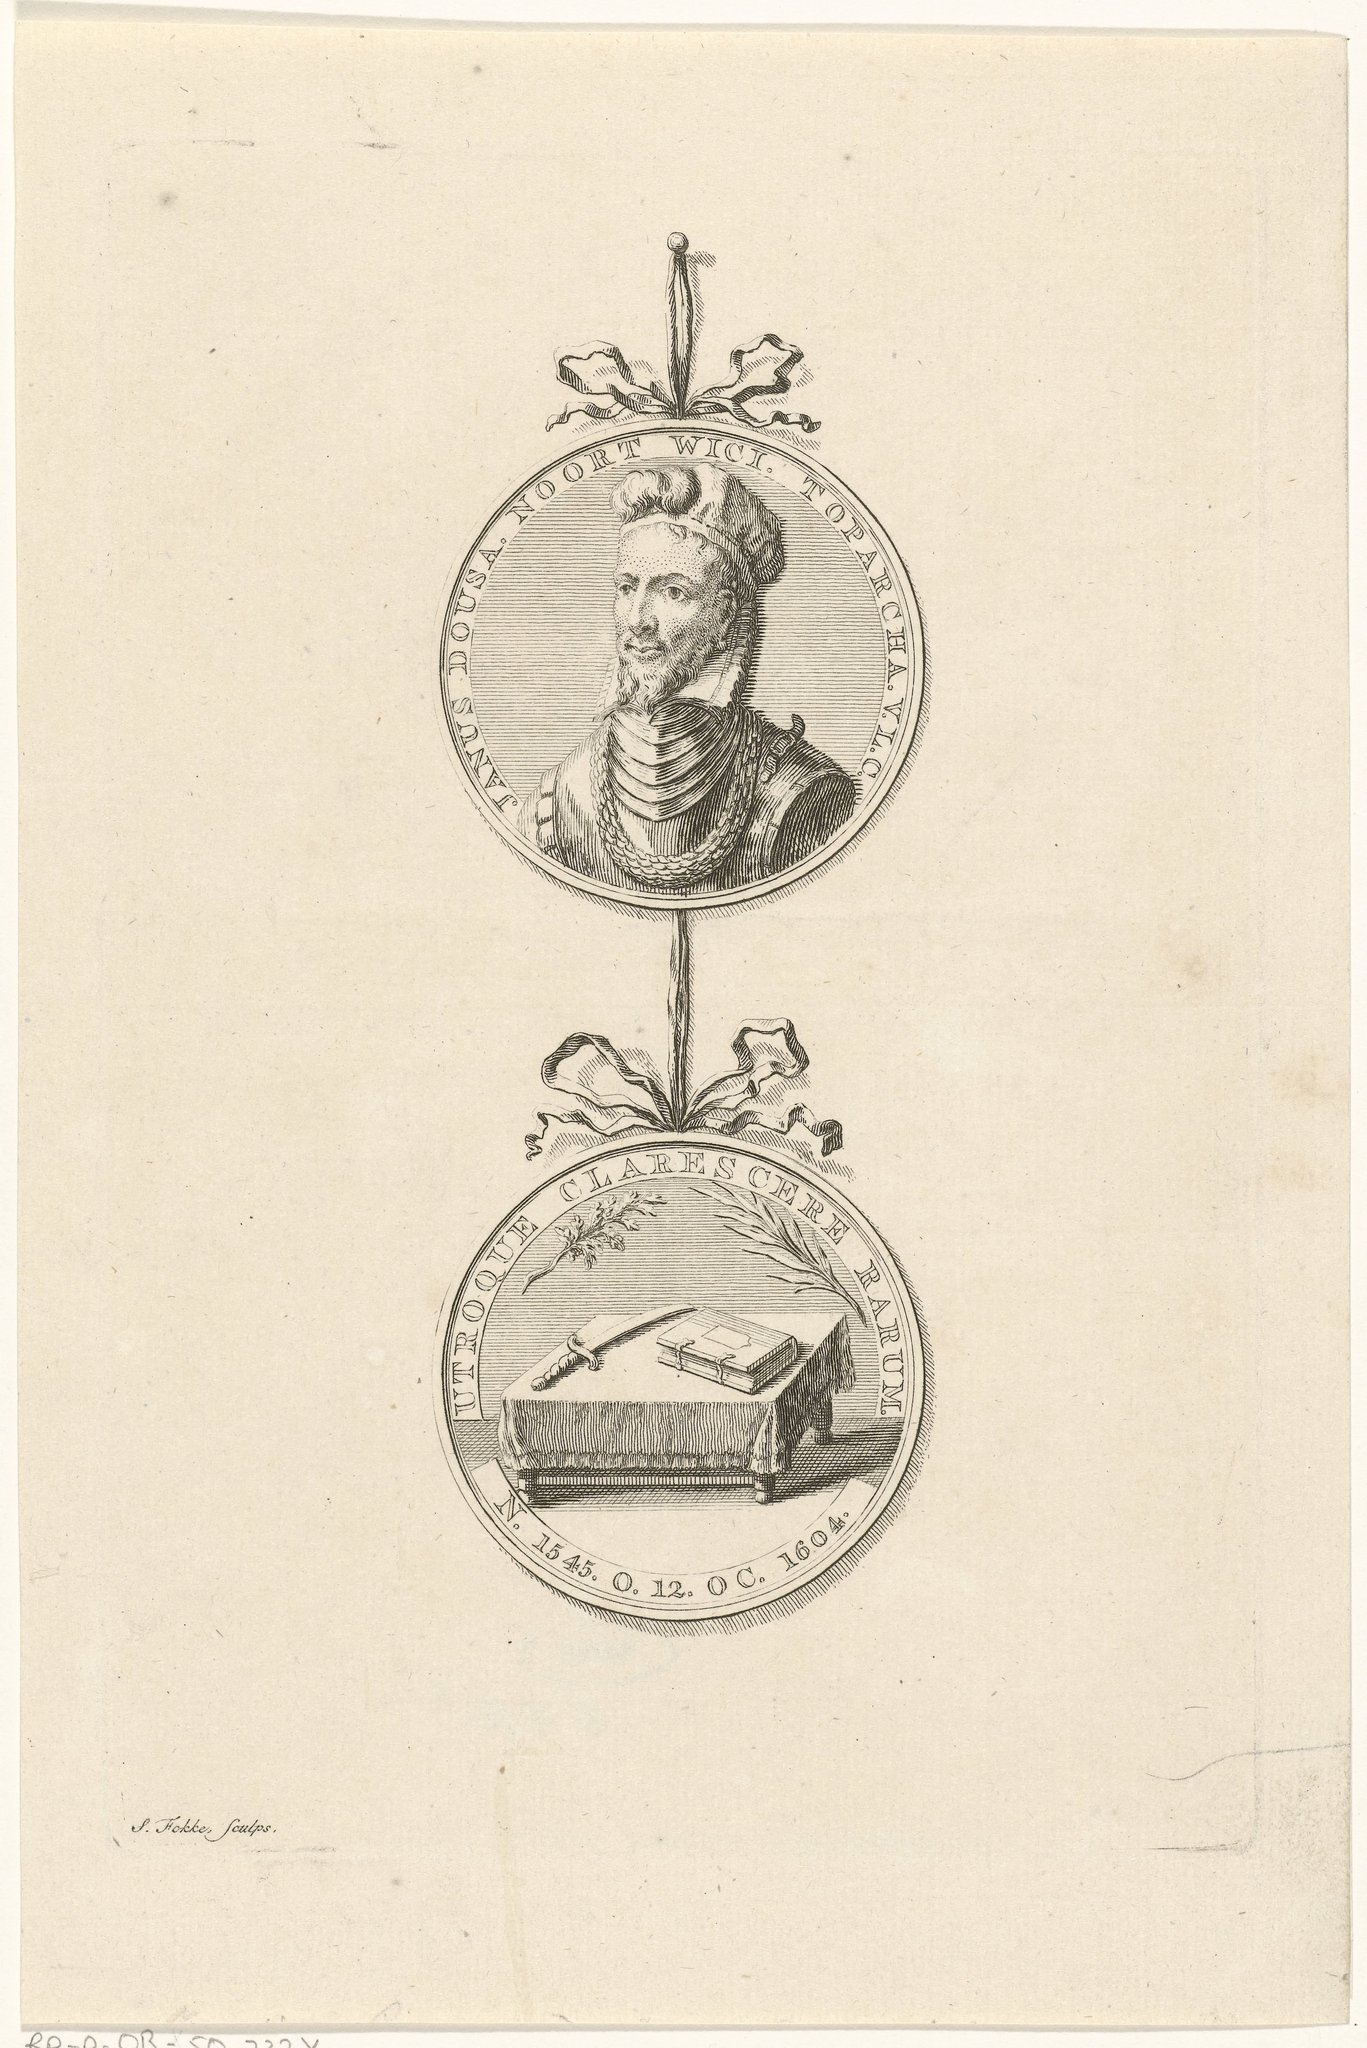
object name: print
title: Gedenkpenning met portret van Johan van der Does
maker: simon fokke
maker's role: draughtsman, print maker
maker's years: 1712-1784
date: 1722-1784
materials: paper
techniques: etching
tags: memorial medal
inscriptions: collector's mark: Lugt 2228